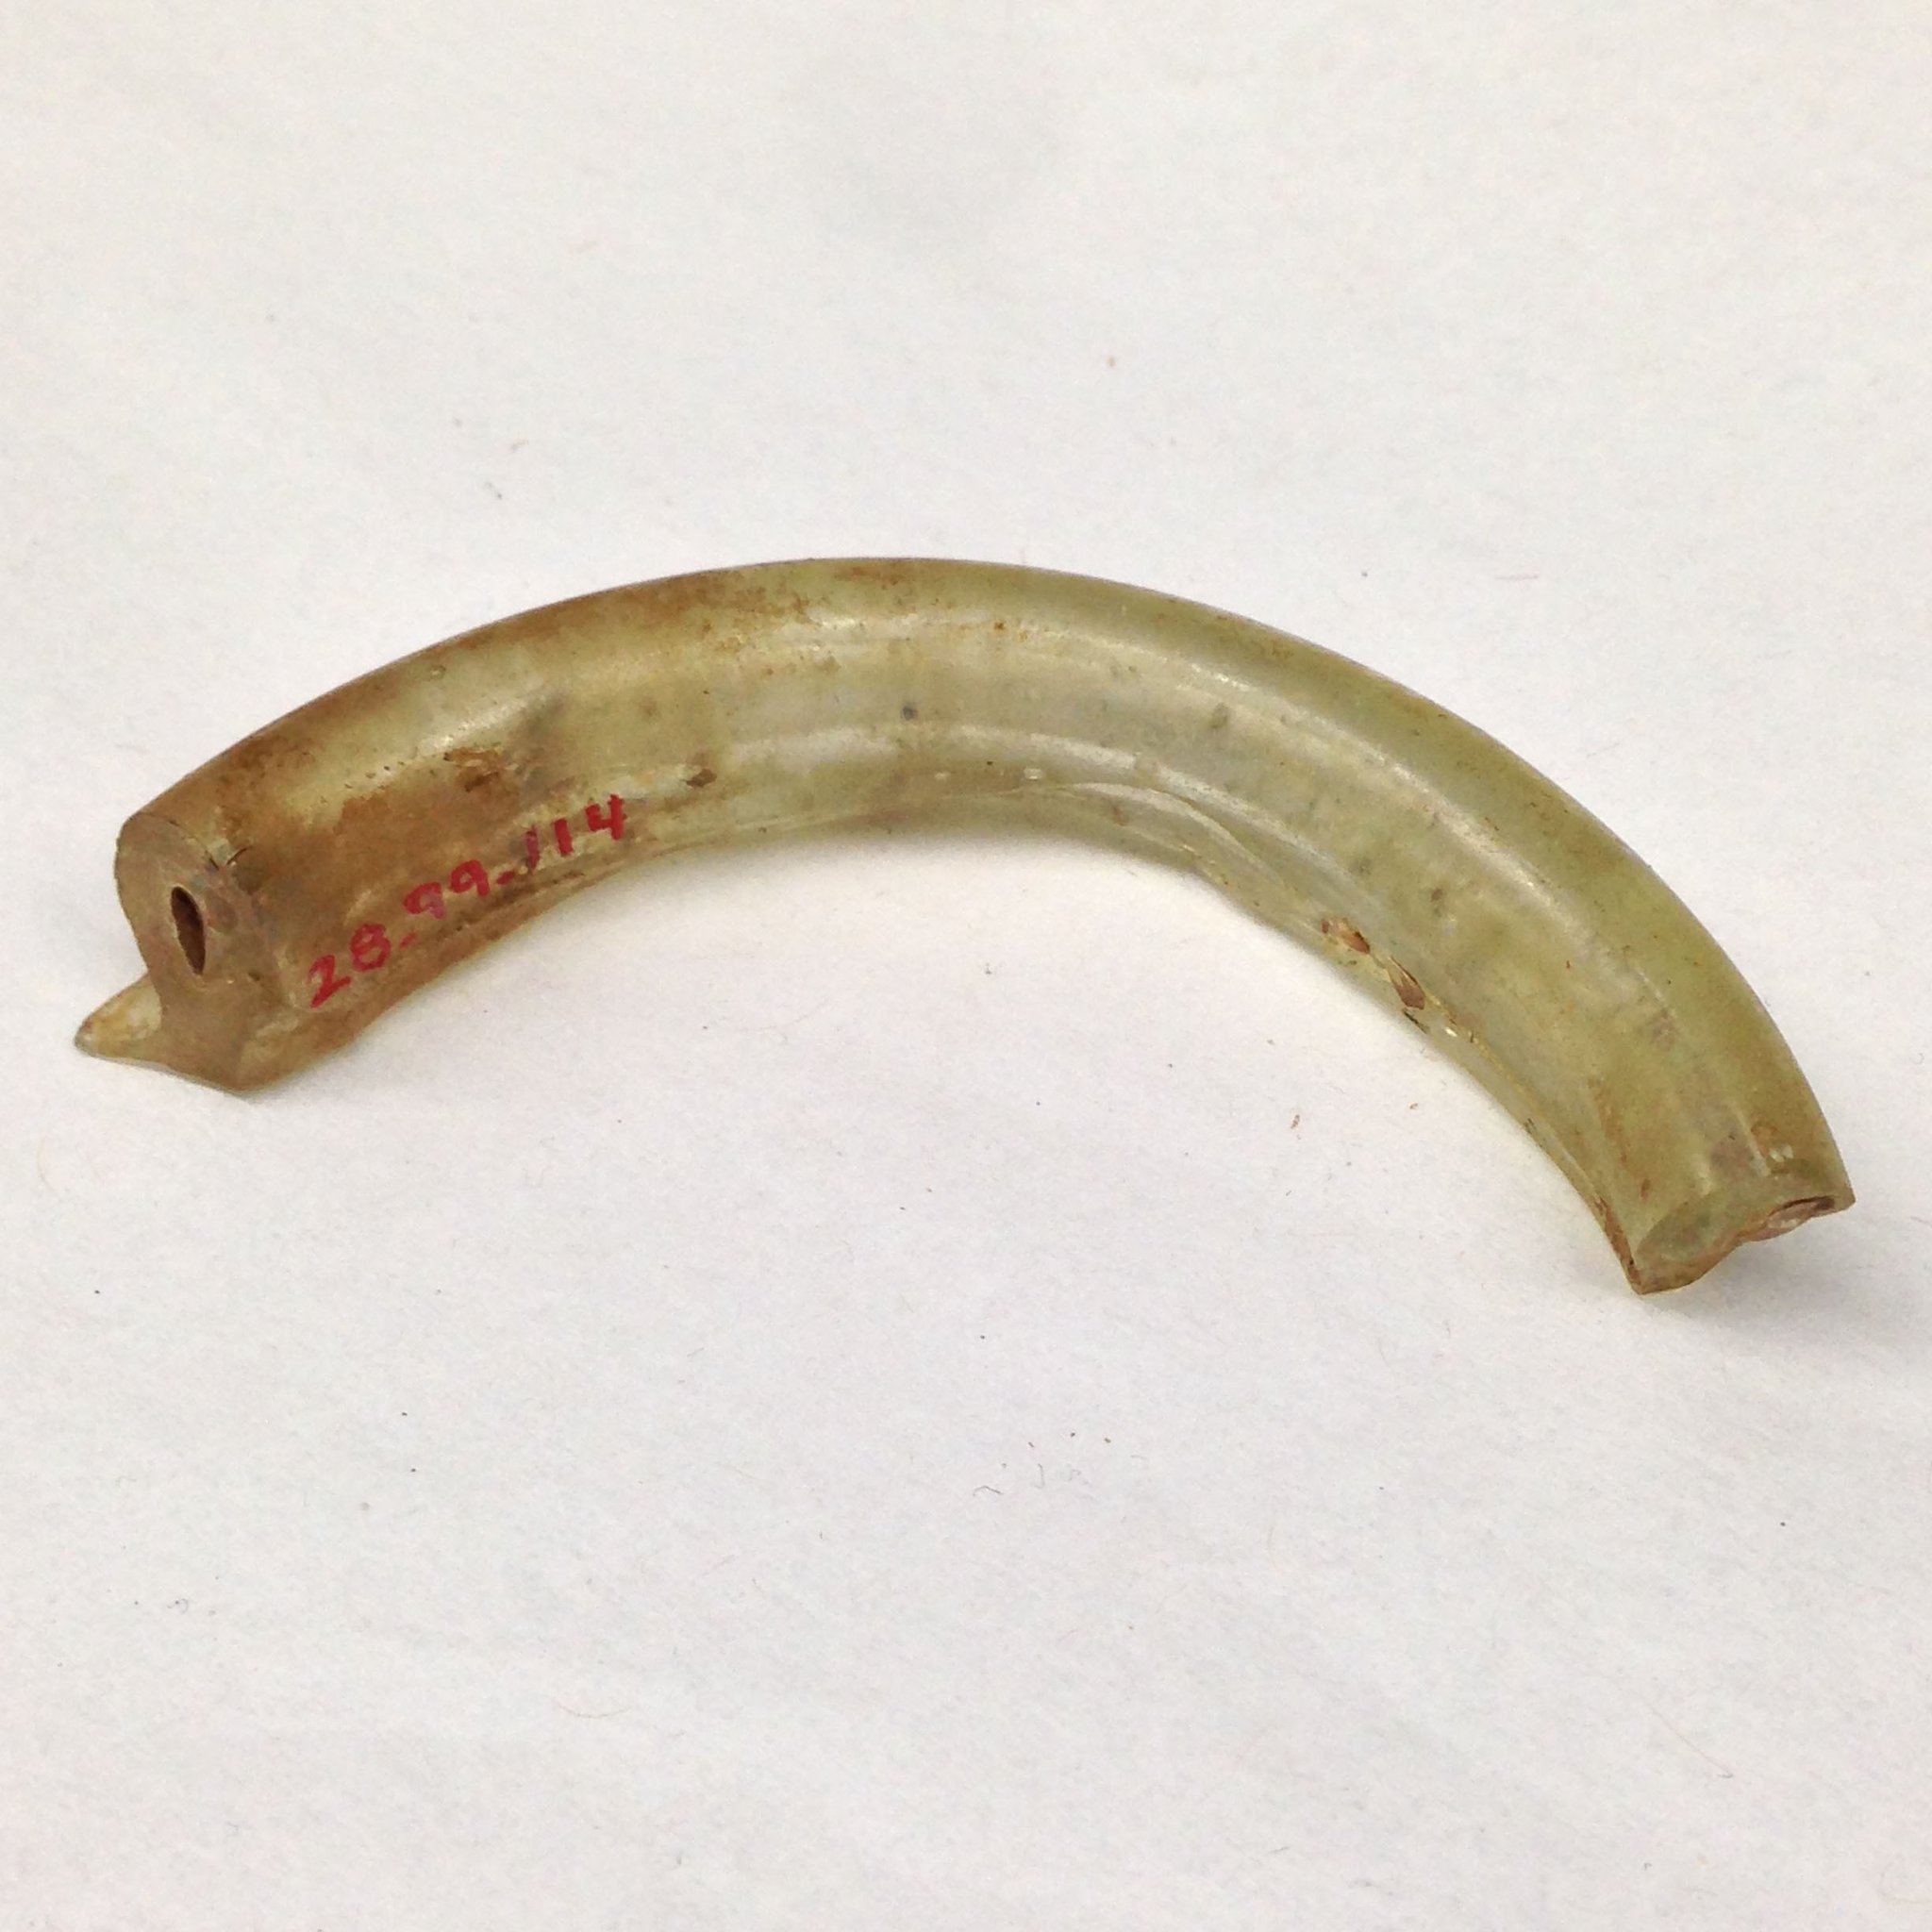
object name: fragment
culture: european or middle eastern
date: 1150-1250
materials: ceramic, glass